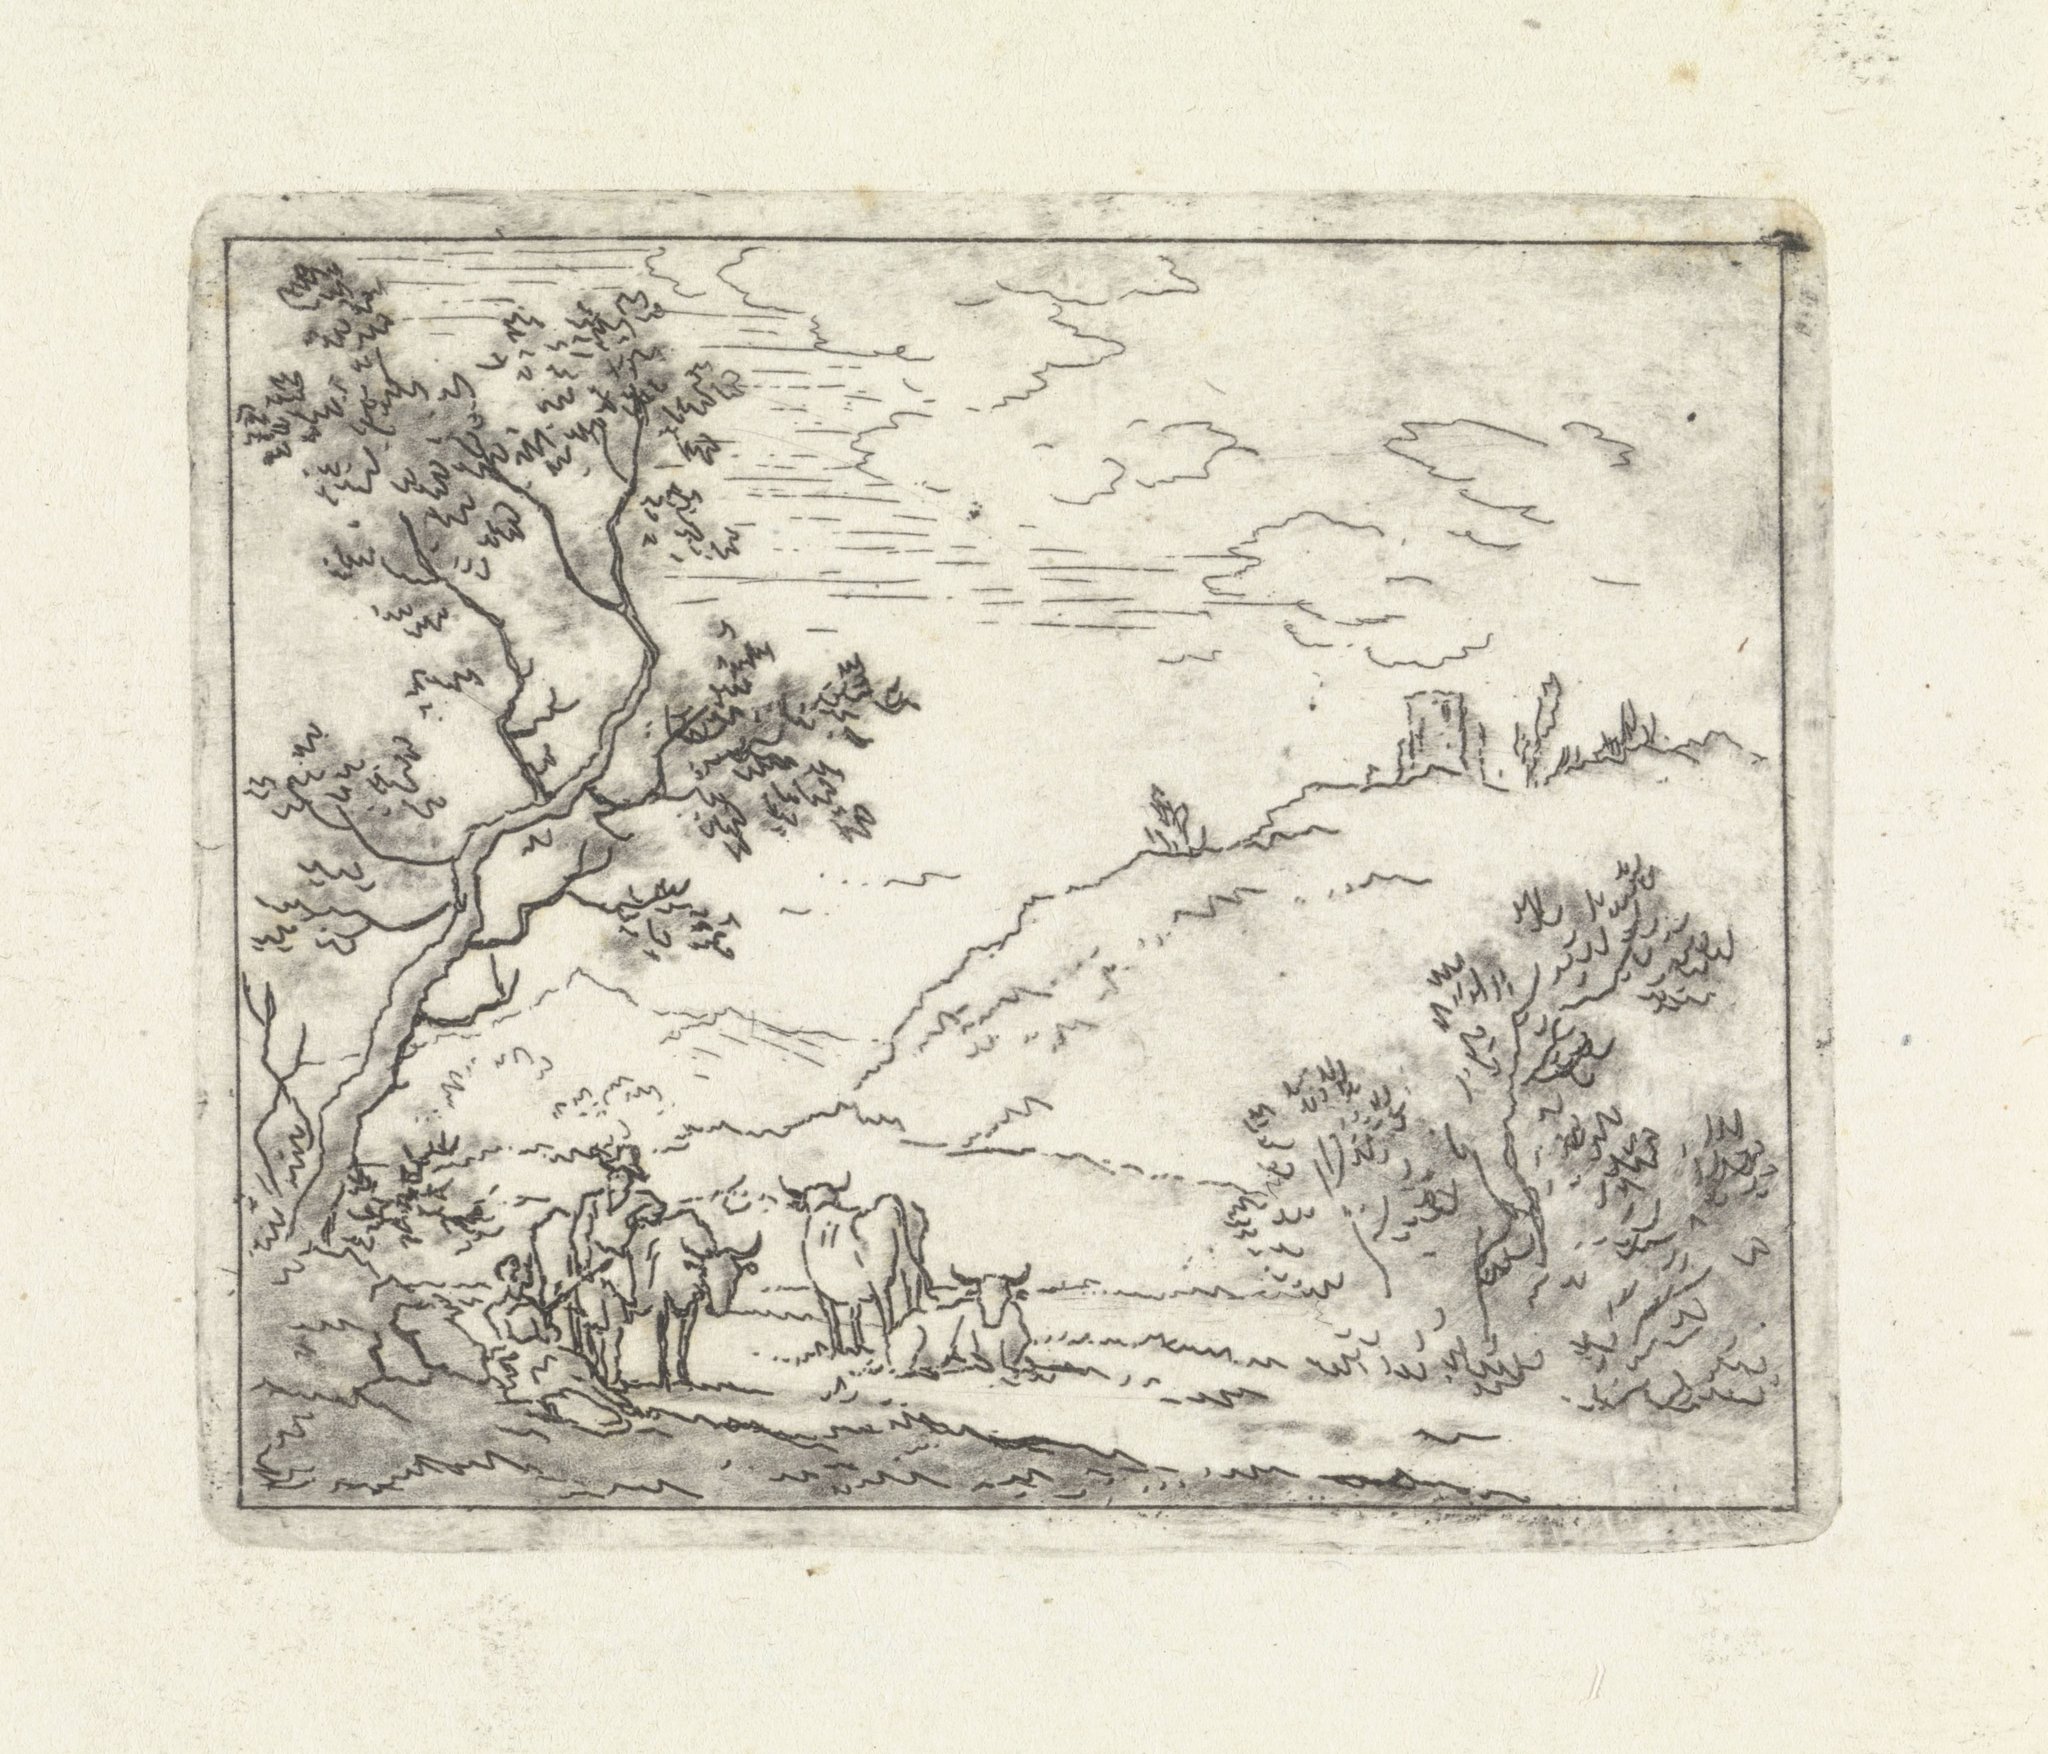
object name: print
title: Landschap met herder en koeien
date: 1739-1851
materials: chalk, paper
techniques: etching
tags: cow, pastorals, arcadian scenes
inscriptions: collector's mark: Lugt 240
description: Heuvelachtig landschap met herder, leunend op een koe, in gesprek met een zittende herderin. Naast hen twee koeien. Op de achtergrond op een heuvel een toren.